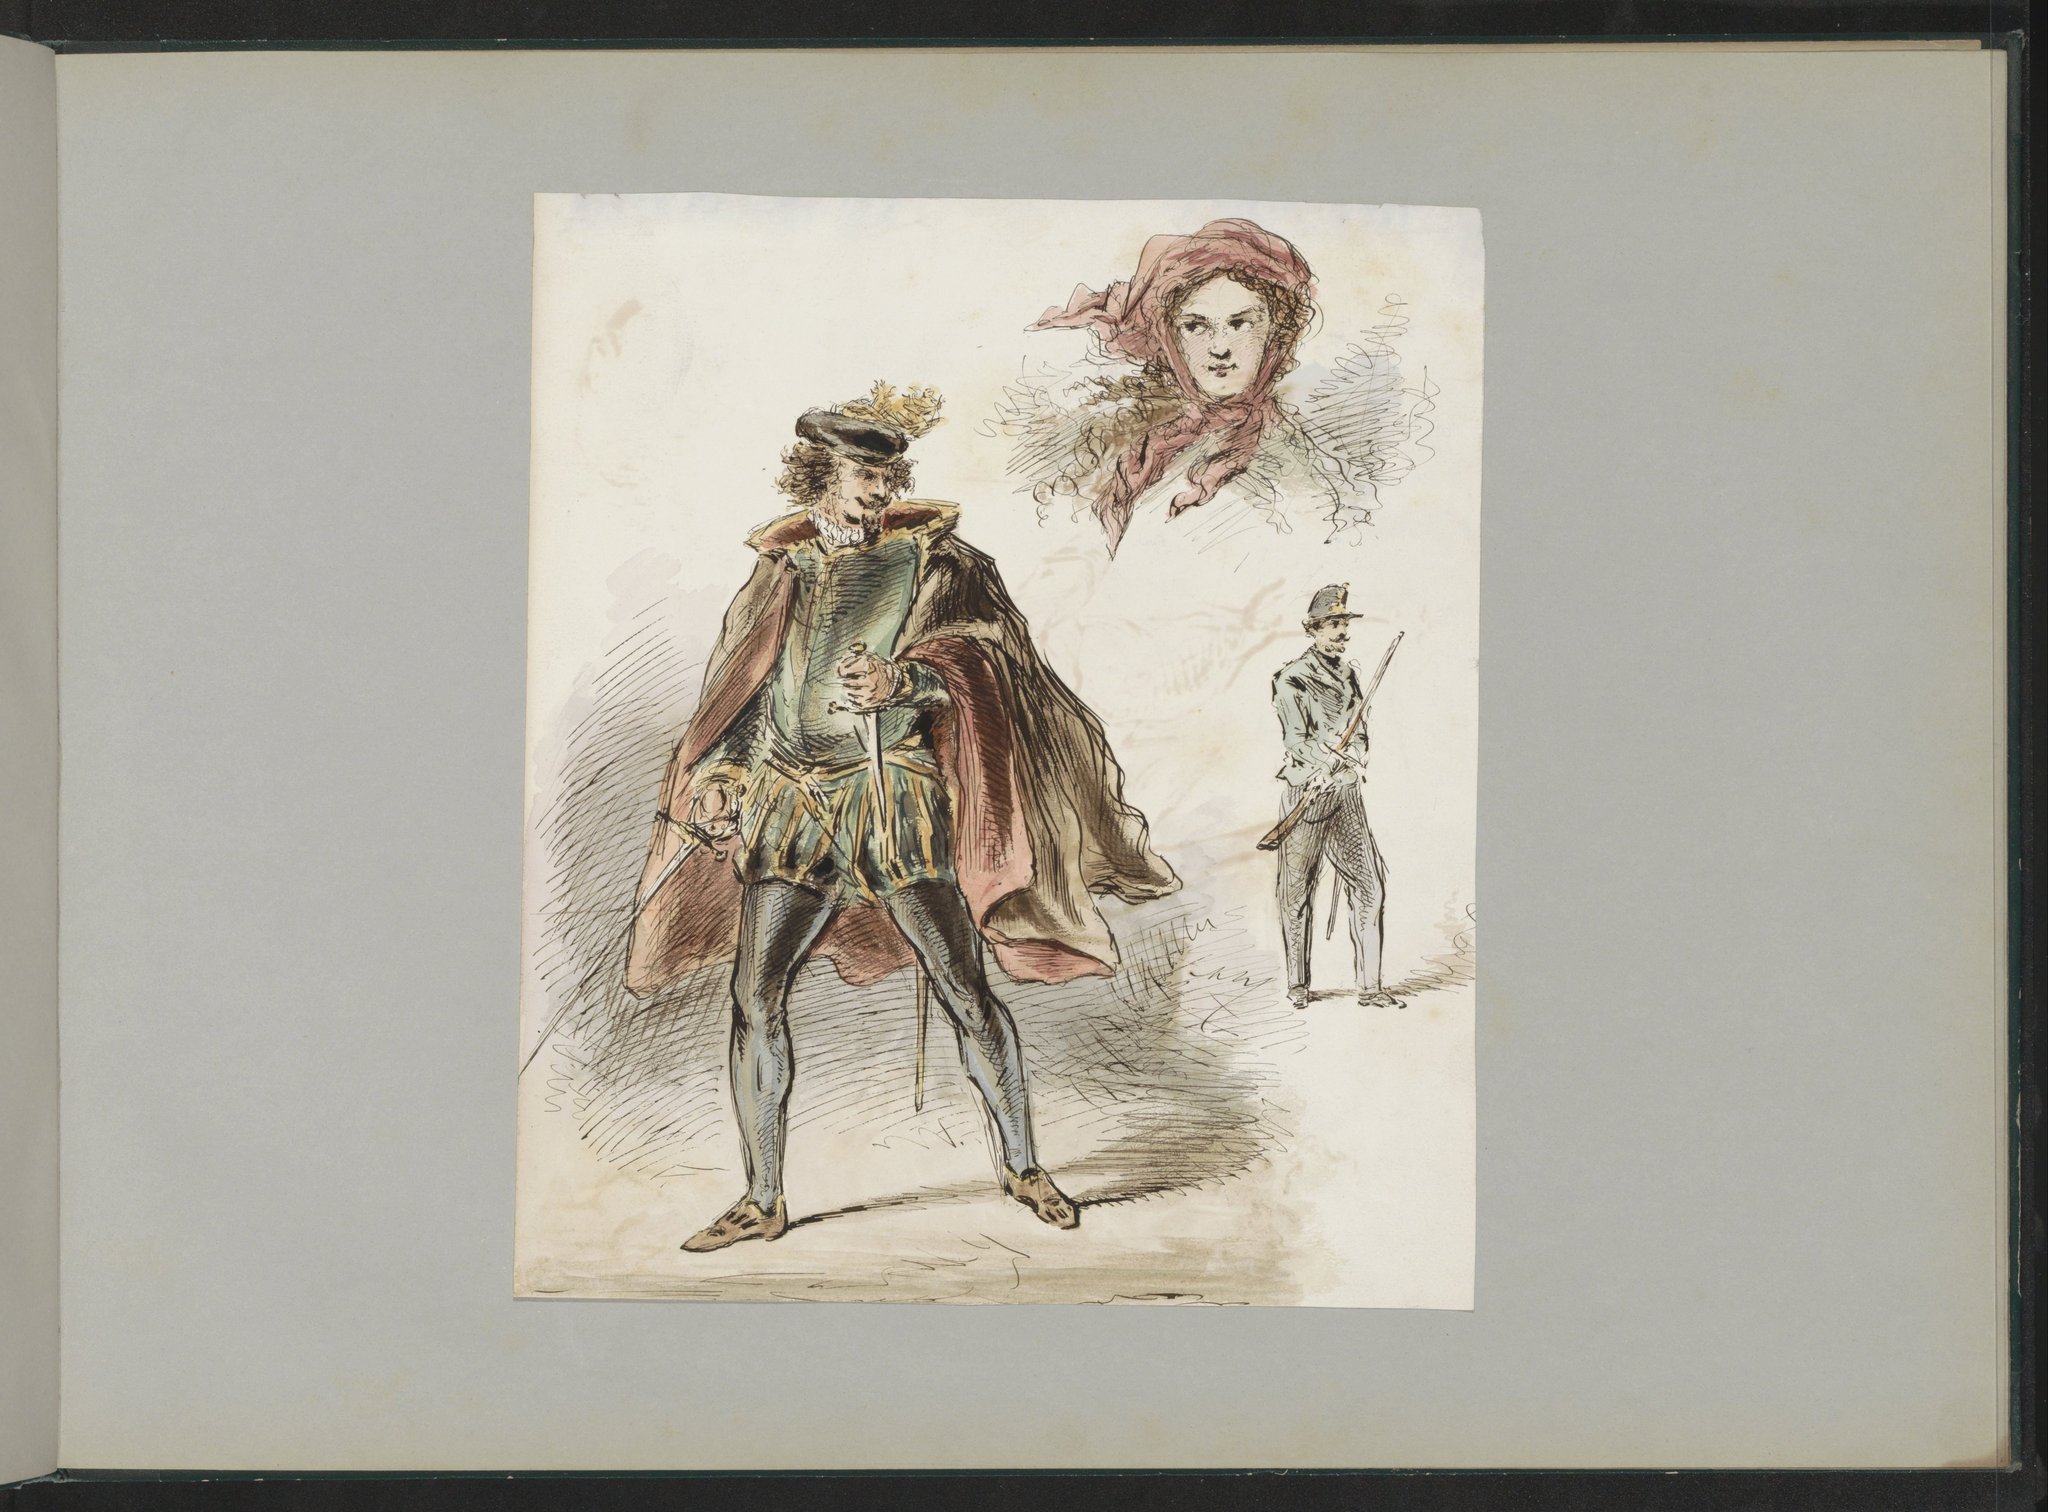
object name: album leaf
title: Man in historisch kostuum, een vrouw met hoofddoek en een soldaat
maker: alexander ver huell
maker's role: draughtsman, print maker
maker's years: 1822-1897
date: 1854-1887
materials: ink, paper, watercolor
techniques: brush, pen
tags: head-gear (with name), folk costume, regional costume (+ men's clothes), (military) uniforms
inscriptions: signature: ‘Avh’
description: Recto van een tekening op blad 13 van een album met 35 tekeningen.